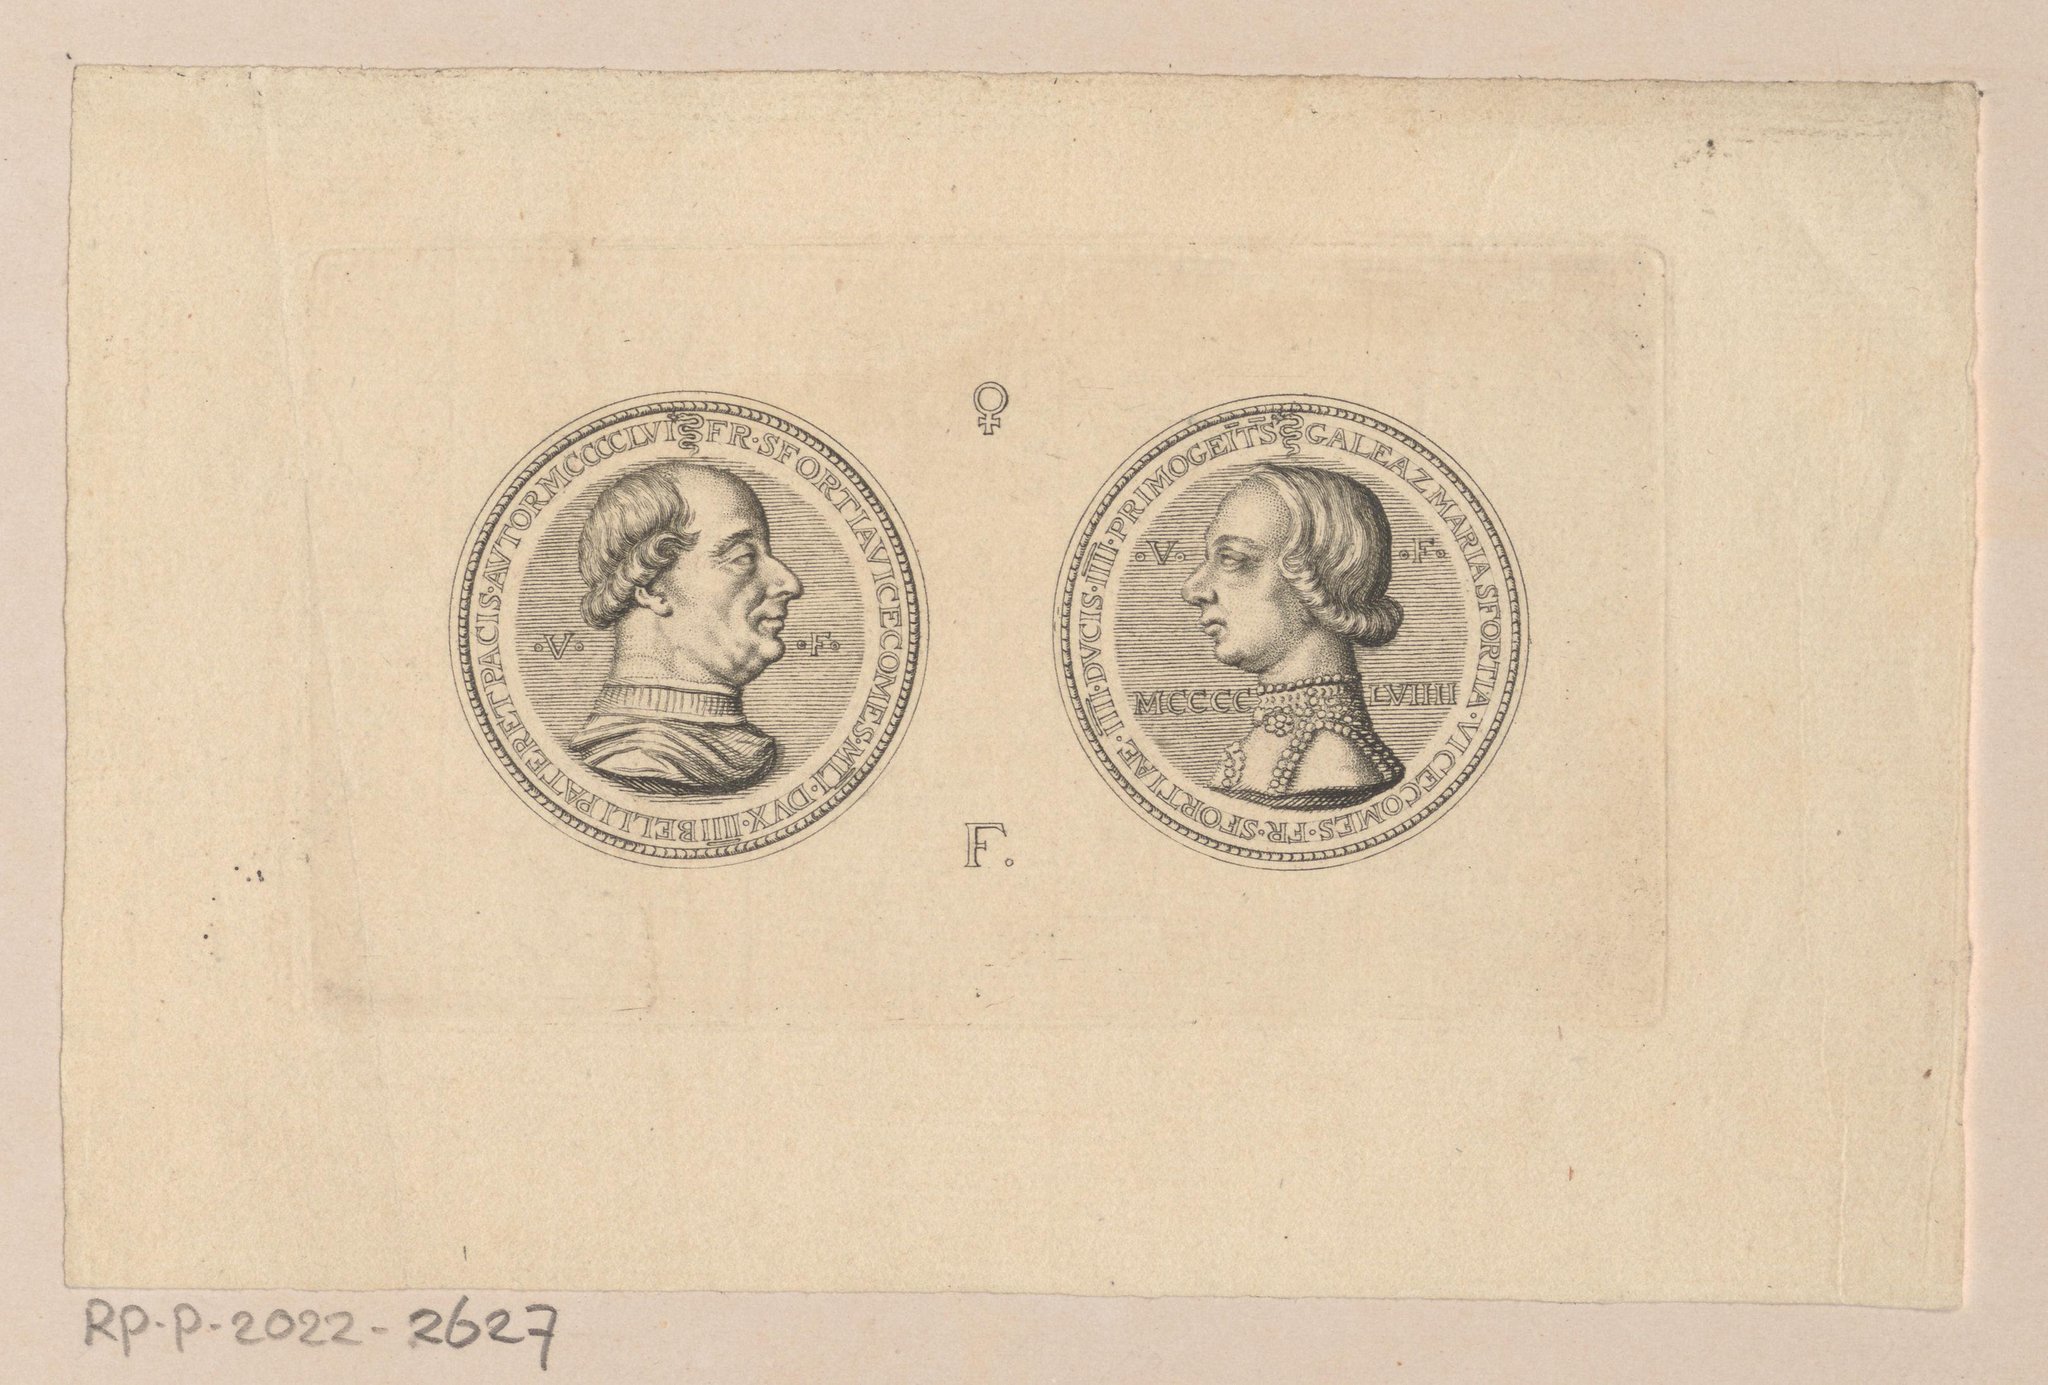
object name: print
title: Penningen met de portretten van Francesco I Sforza en Galeazzo Maria Sforza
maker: Anonymous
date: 1732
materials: paper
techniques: etching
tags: historical persons, other sovereign (with title)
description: Prent waarschijnlijk uit: Mieris, Frans van. Histori der nederlandsche vorsten, uit de huizen van Beijere, Borgonje, en Oostenryk. Den Haag: Pieter de Hondt, 1732.